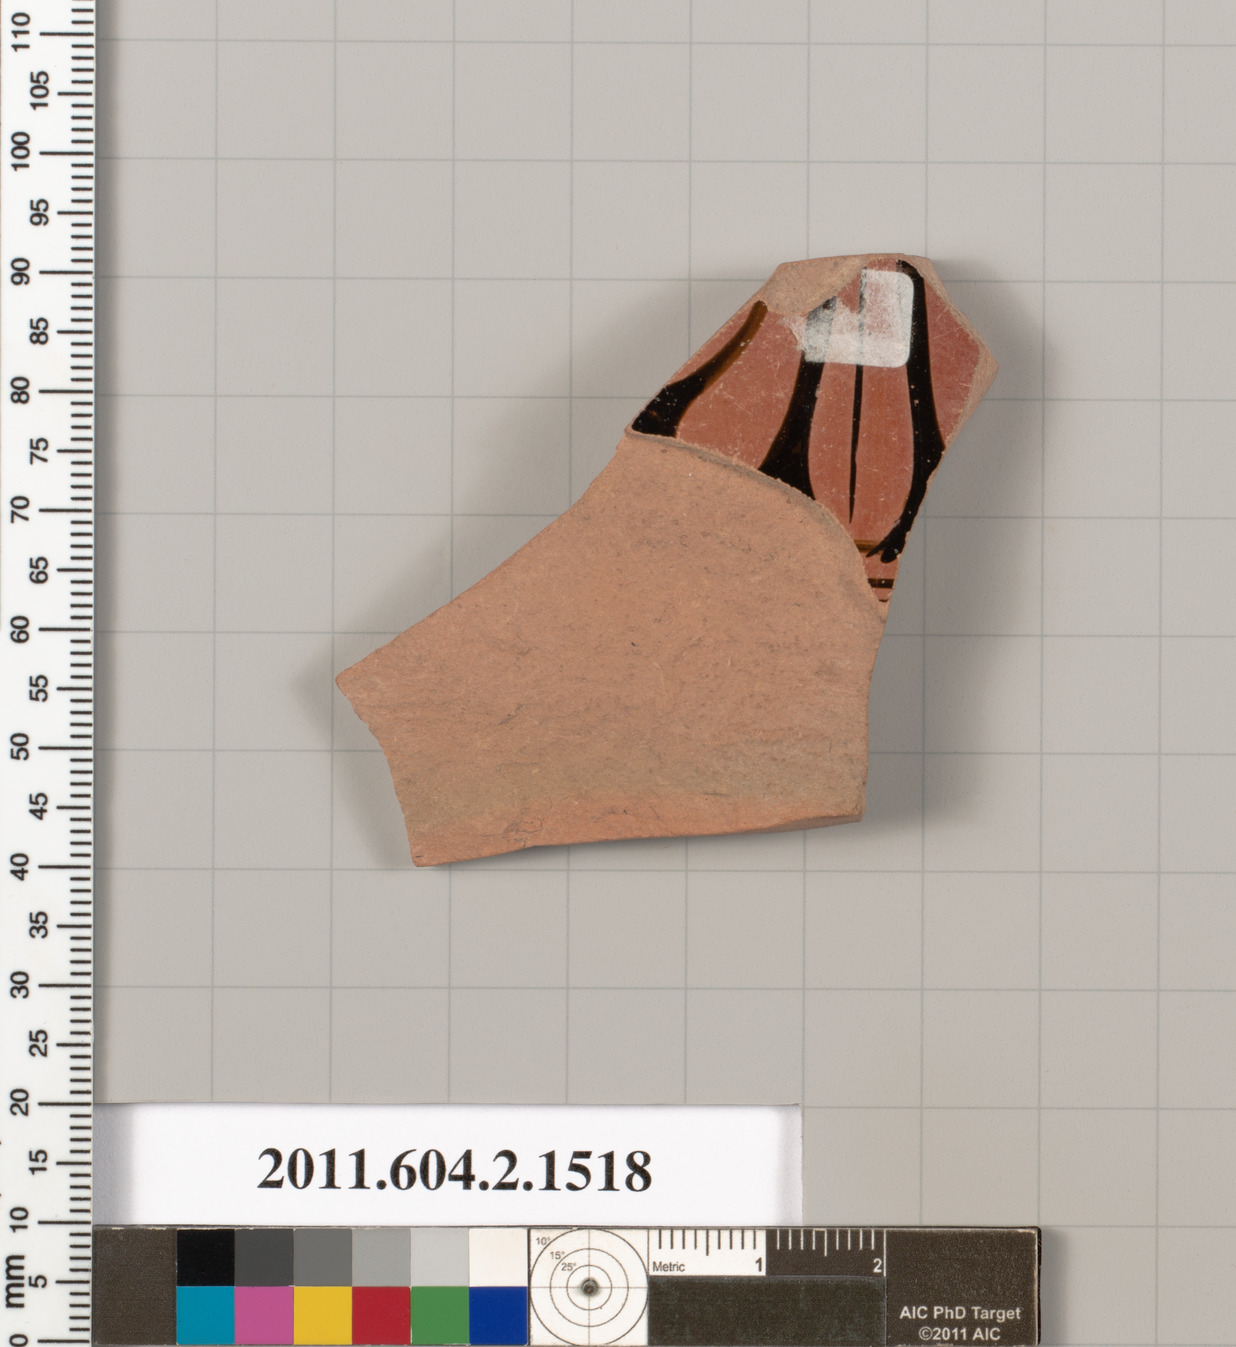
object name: skyphos fragment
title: Terracotta fragment of a skyphos (deep drinking cup)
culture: greek, attic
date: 475-451 BCE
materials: terracotta